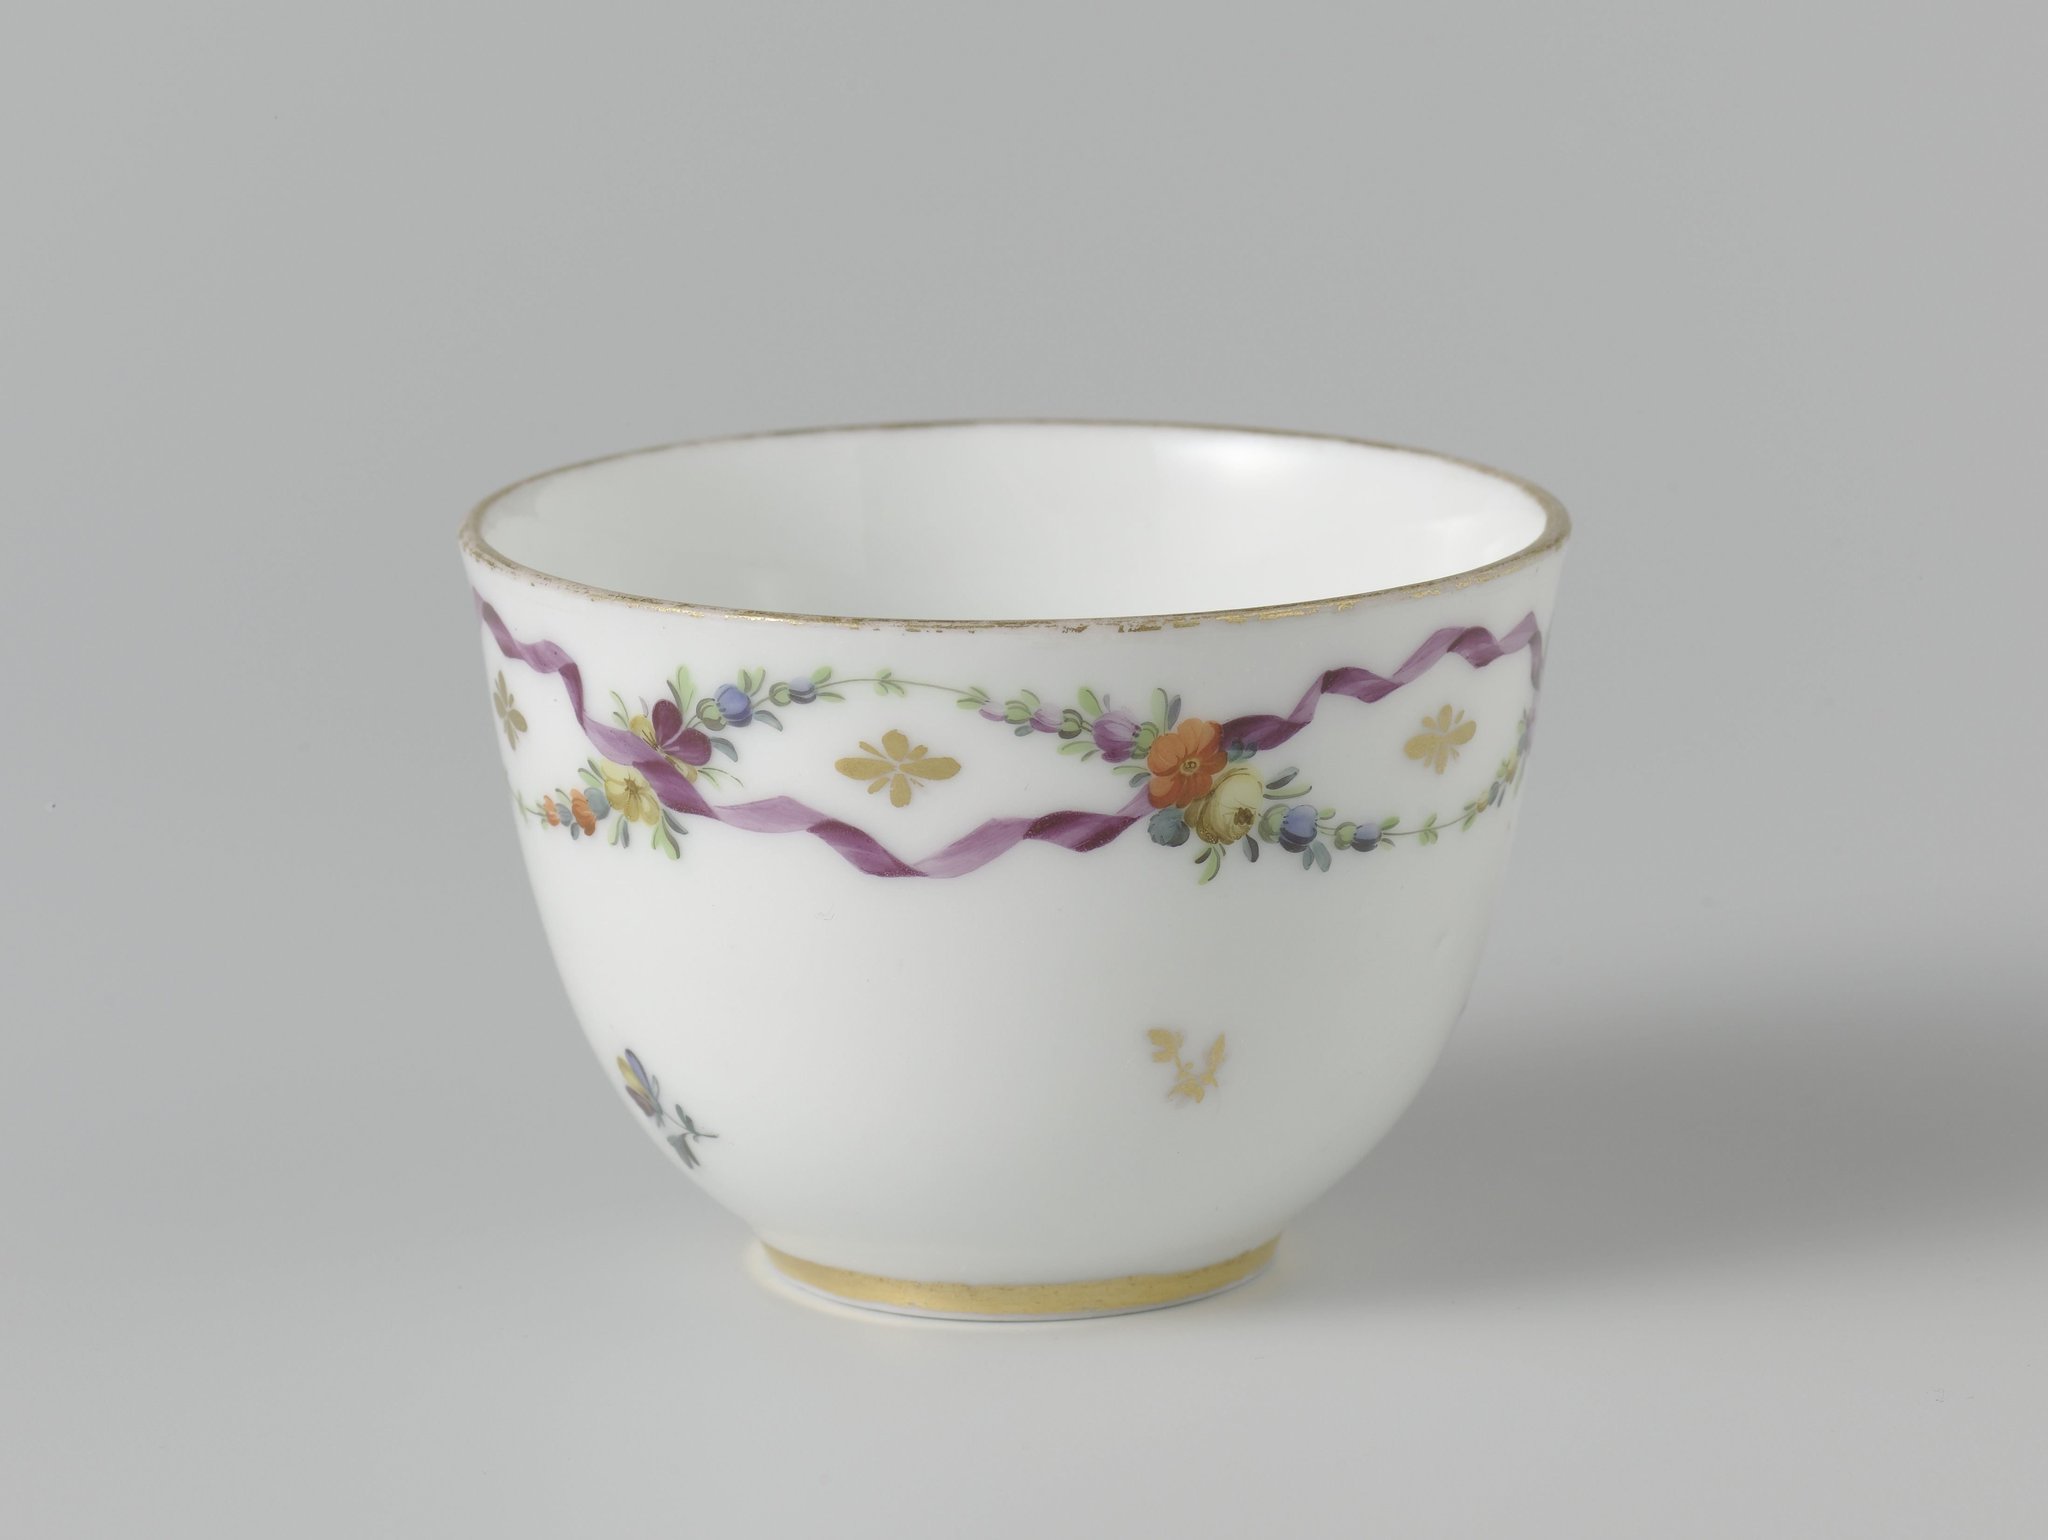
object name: cup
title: Kop zonder oor, beschilderd met strooibloemen en gouden lovertjes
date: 1809-1814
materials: porcelain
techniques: painted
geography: nieuwer-amstel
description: Tea service. Porcelain. Ouder-Amstel, c. 1790 - 1800. Factory under the direction of Friedrich Daeuber. Given by Mr and Mrs J.F. Heijbroek-Leendertz, 1985.